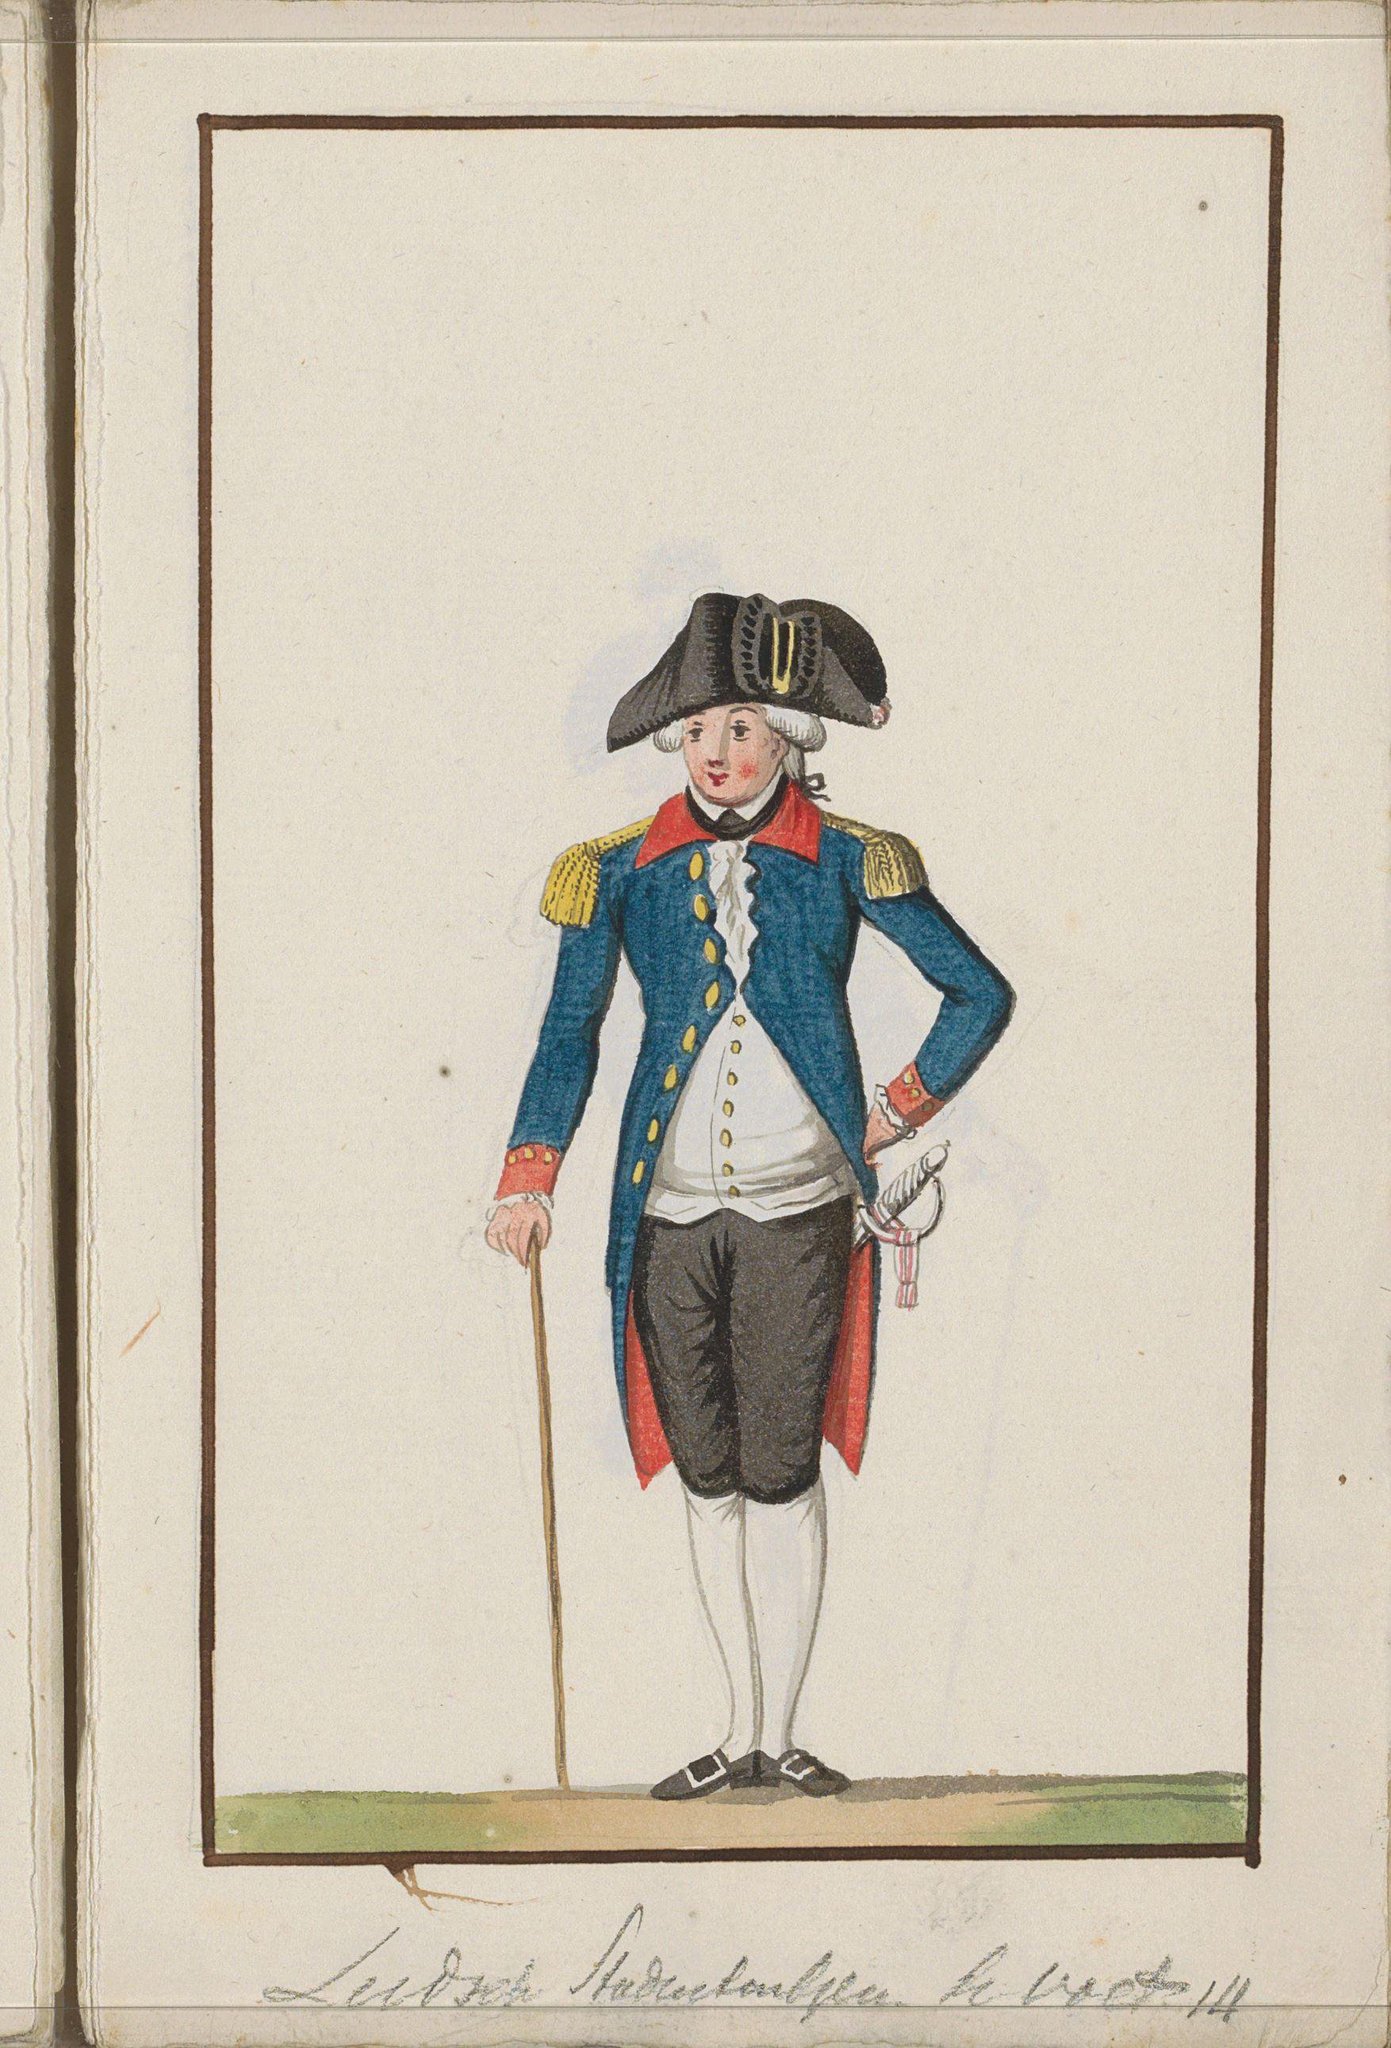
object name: costume print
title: Leyde Studente genootschap te voet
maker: Anonymous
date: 1789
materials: paper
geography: northern netherlands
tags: (military) uniforms (+ citizen soldiery, civil guard, citizen militia), leiden, patriots (1780-1795)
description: Montering of uniform van de infanterie van het exercitiegenootschap van Leidse studenten, ca. 1785. Onderdeel van een schetsboek met 41 gekleurde tekeningen van de monteringen van de gewapende schutterijen en burgercorpsen in Nederland in de periode ca. 1783-1789.